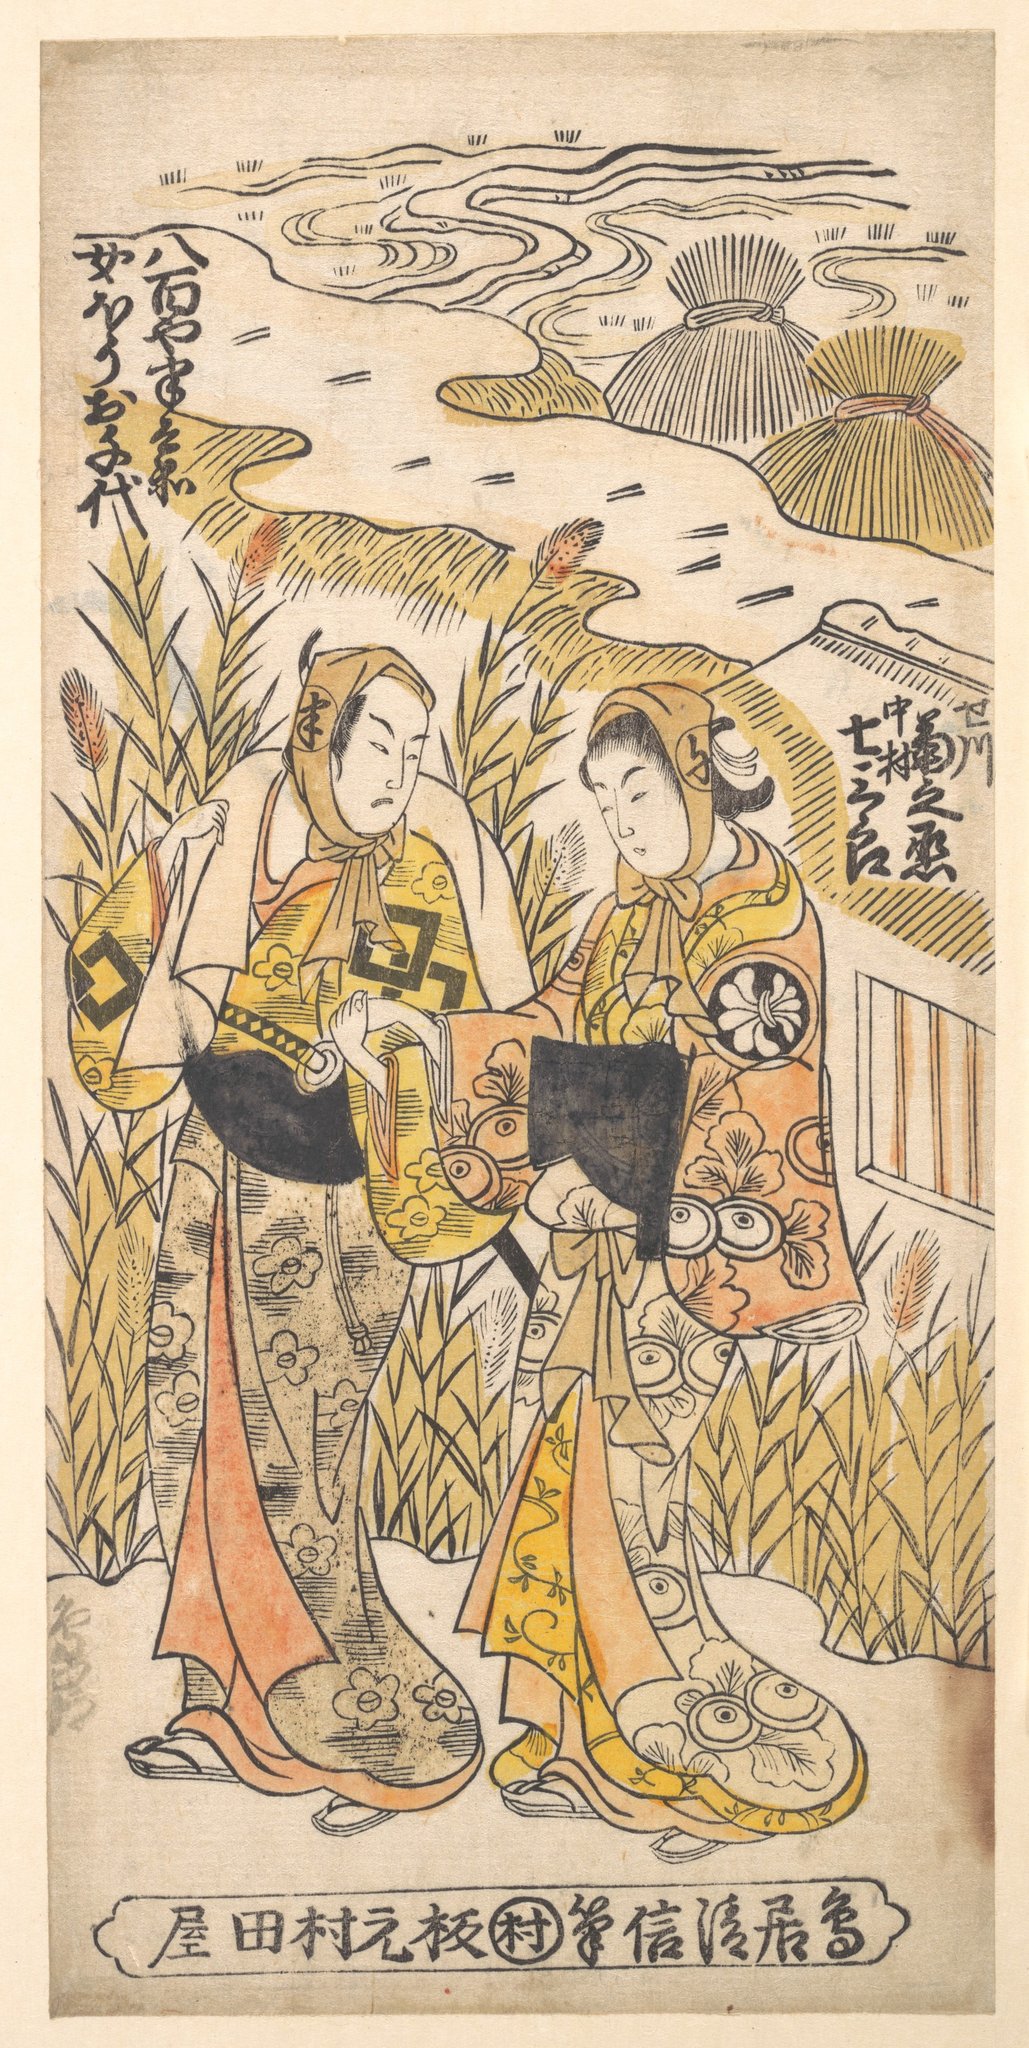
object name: woodblock print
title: Scene from a Drama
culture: japanese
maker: torii kiyonobu ii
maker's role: artist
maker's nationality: japanese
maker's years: 1702-1752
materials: ink, paper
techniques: woodblock print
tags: men,women,plants,actors